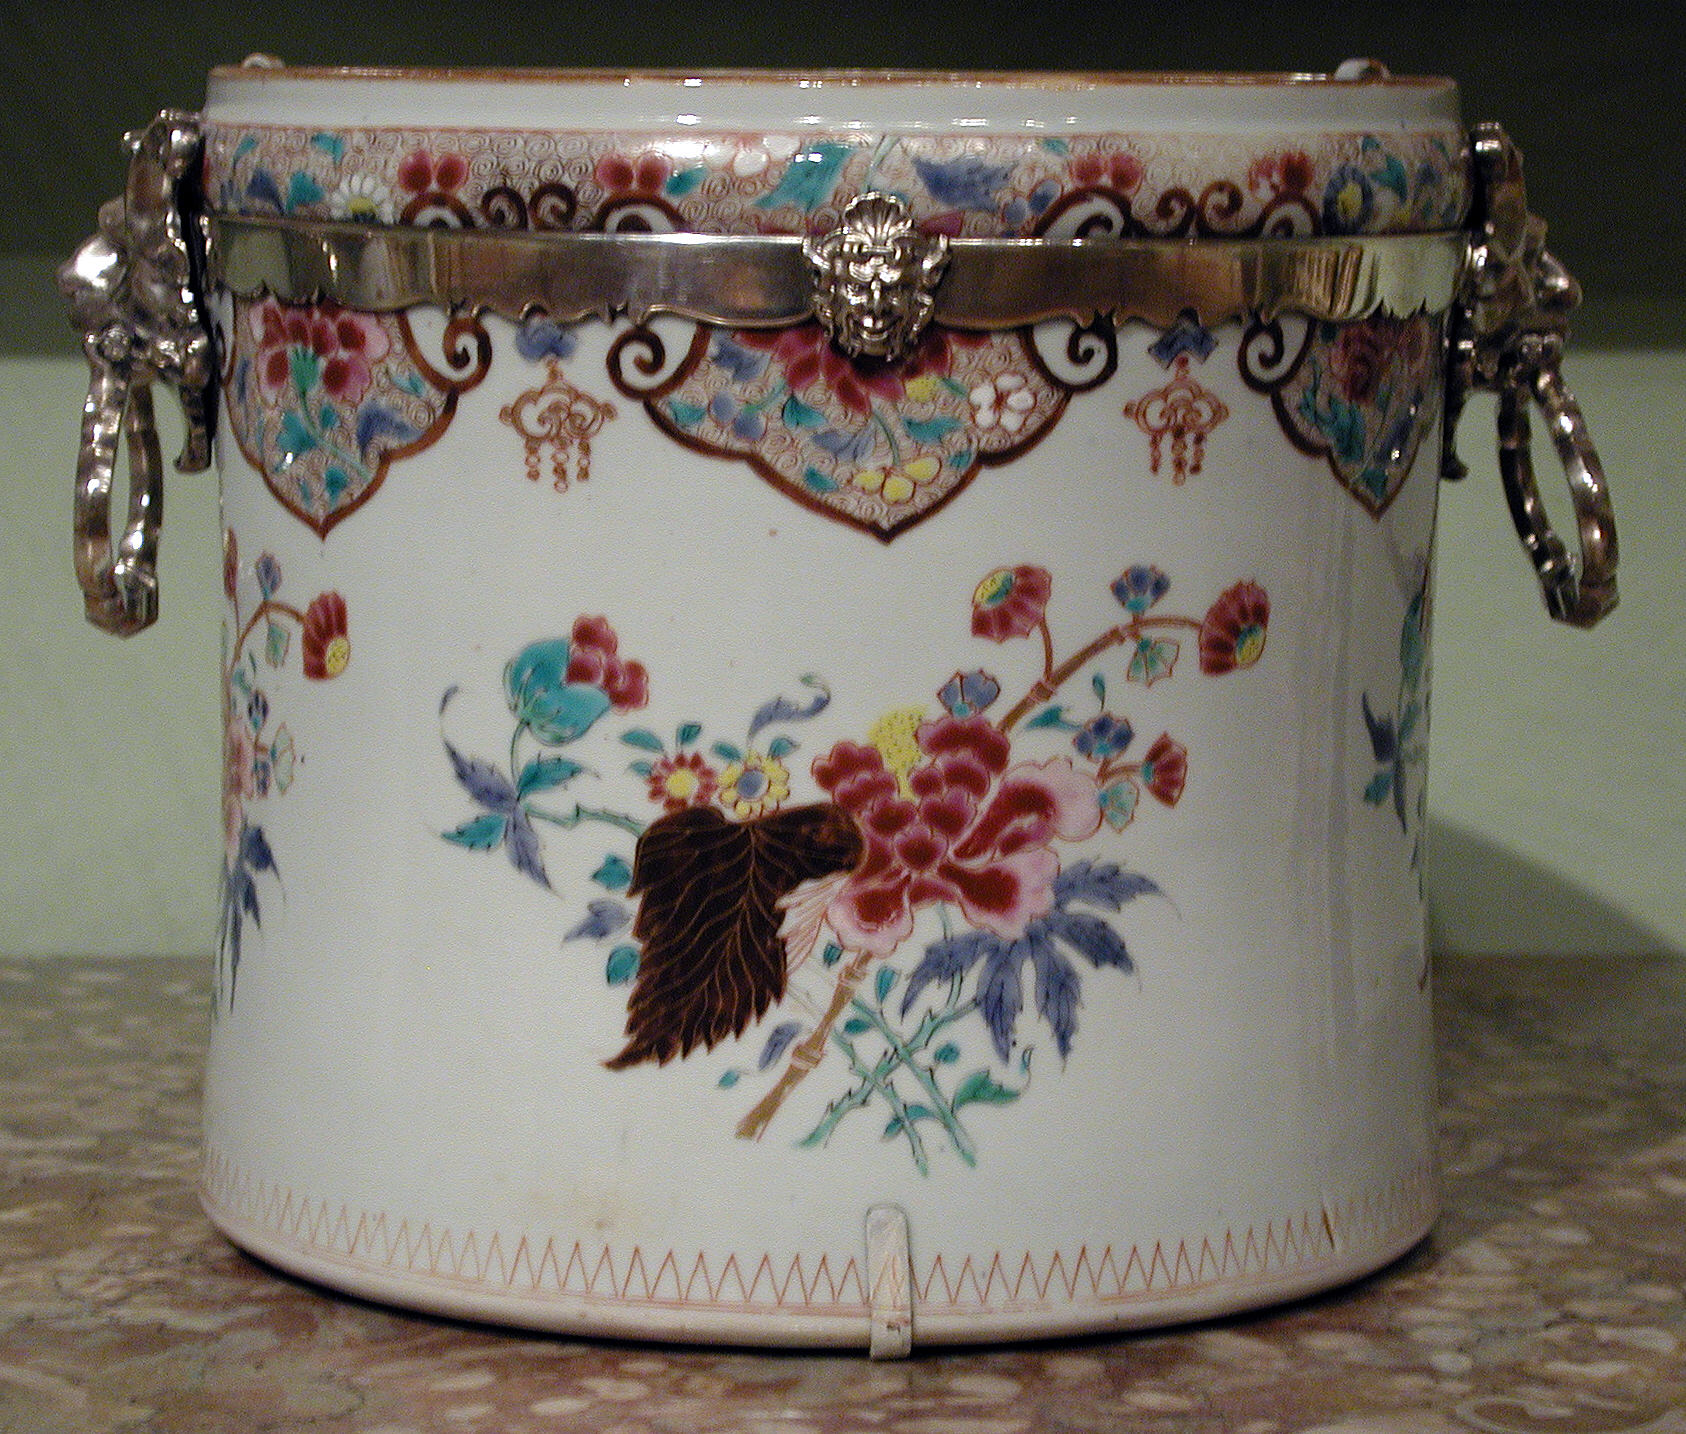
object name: wine cooler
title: Wine cooler (one of a pair)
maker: elias adam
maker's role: mount maker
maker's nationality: german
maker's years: 1669-1745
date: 1735-1736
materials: hard paste porcelain, silver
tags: faces,flowers